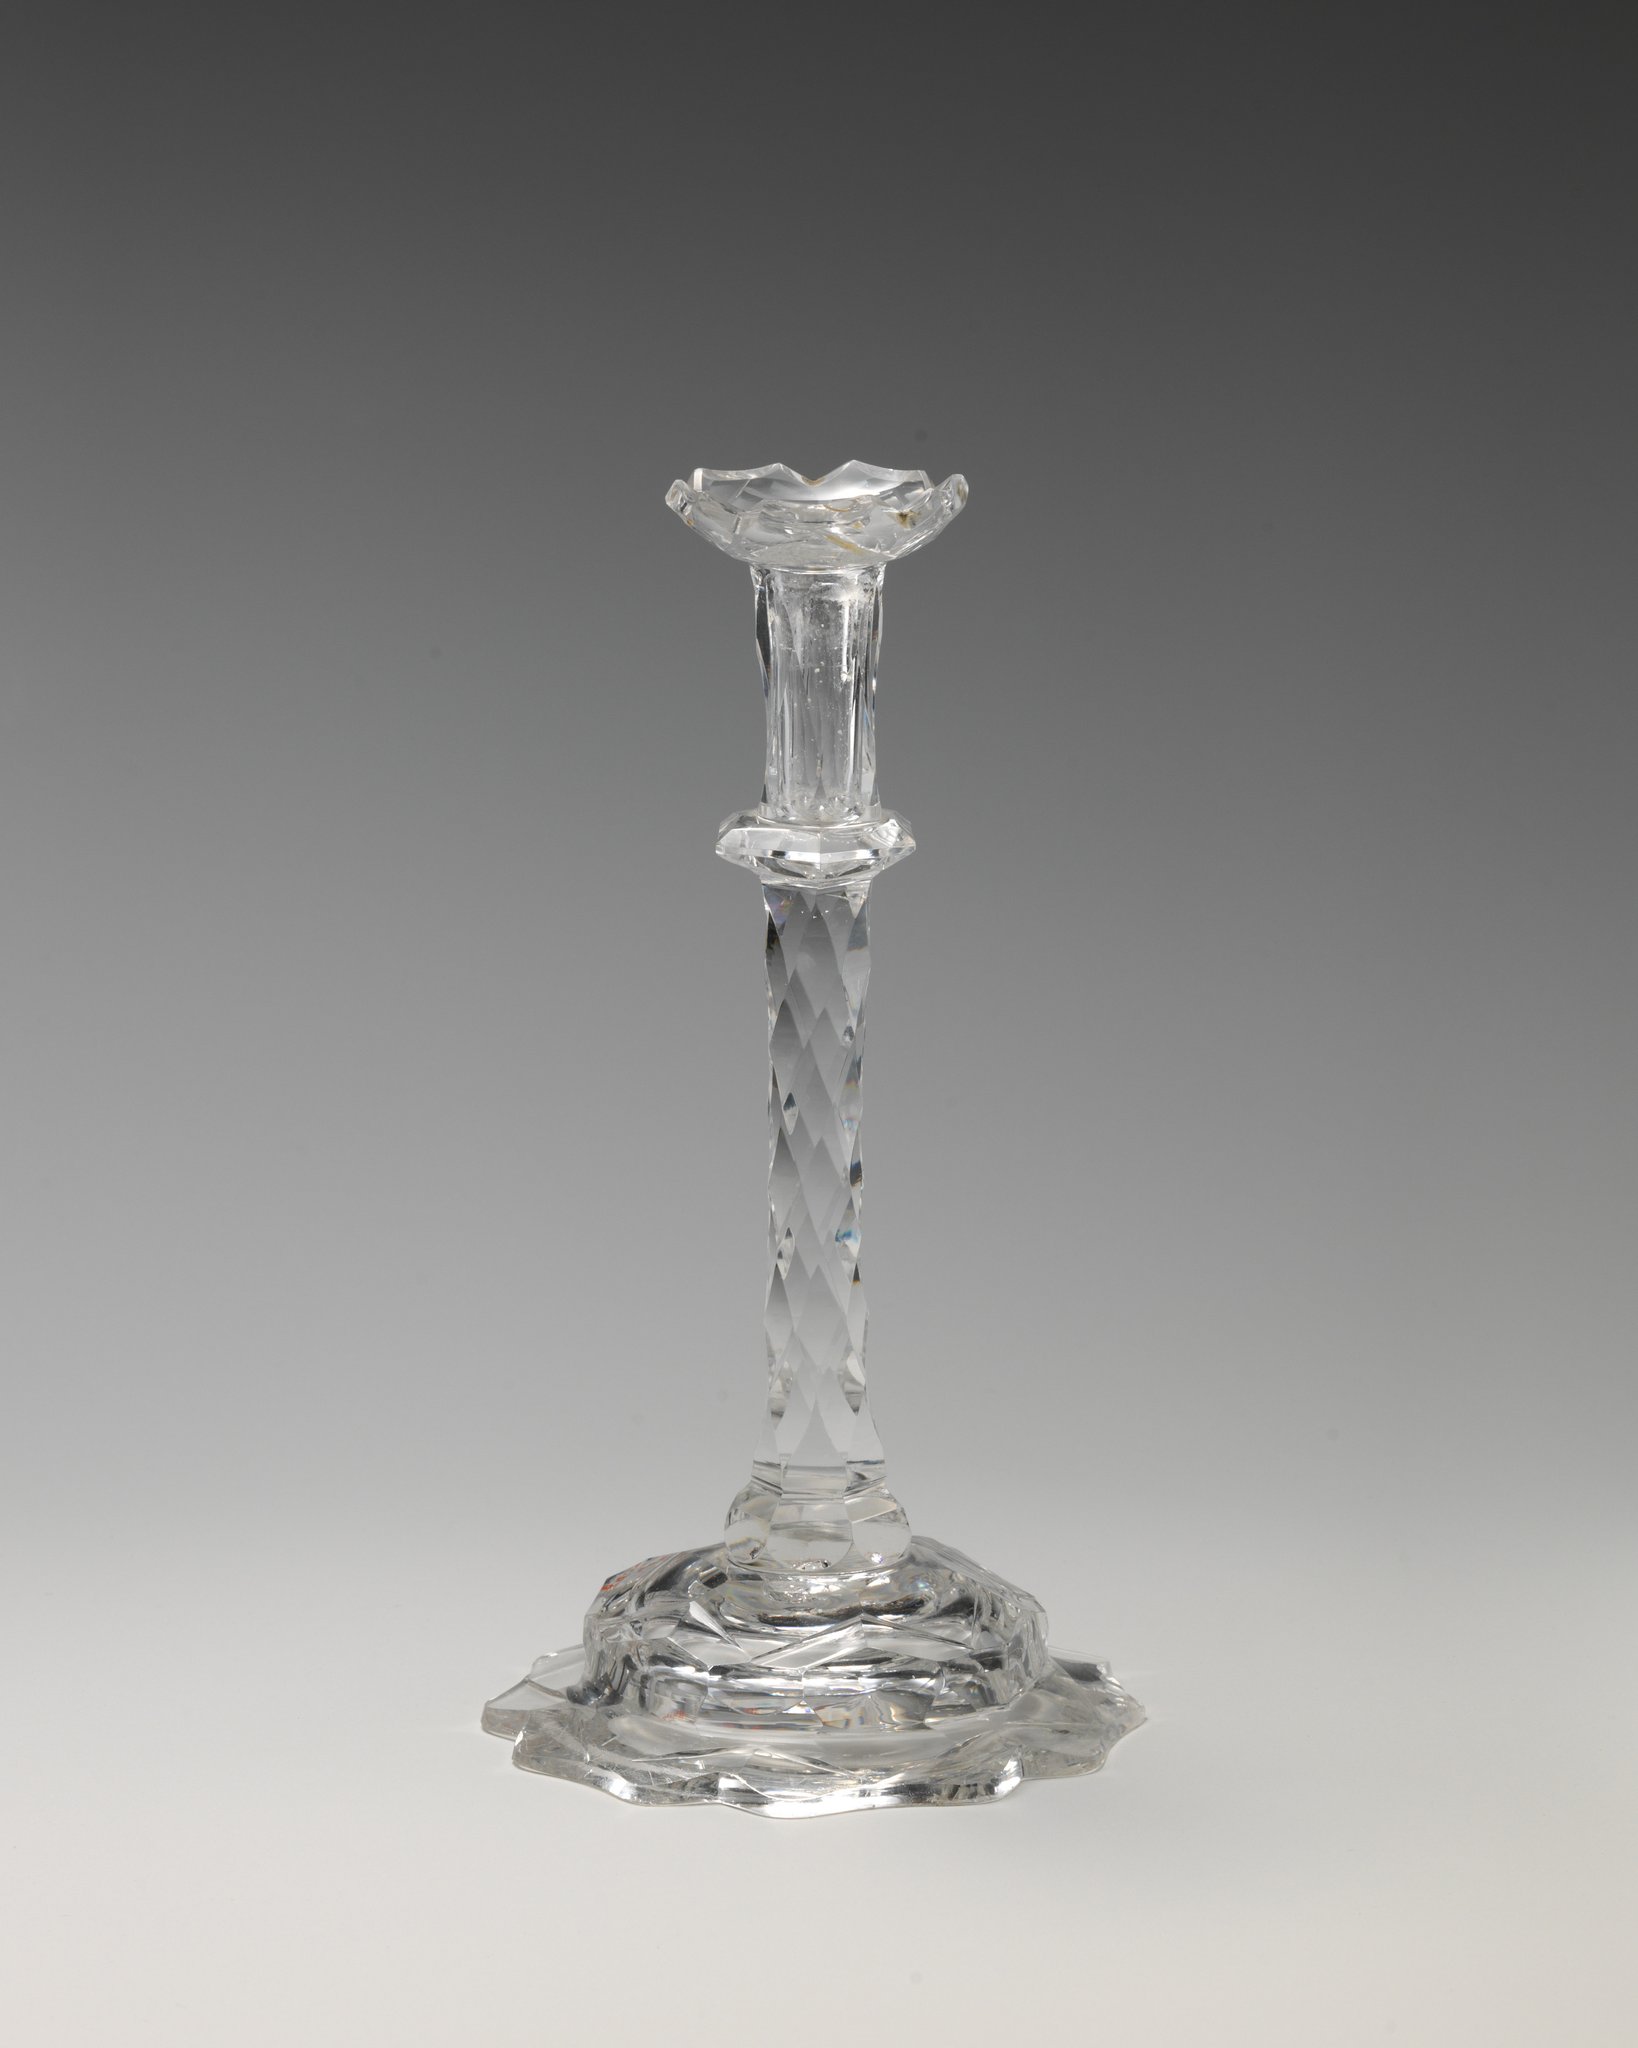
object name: taperstick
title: Taperstick (one of a pair)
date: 1775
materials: glass